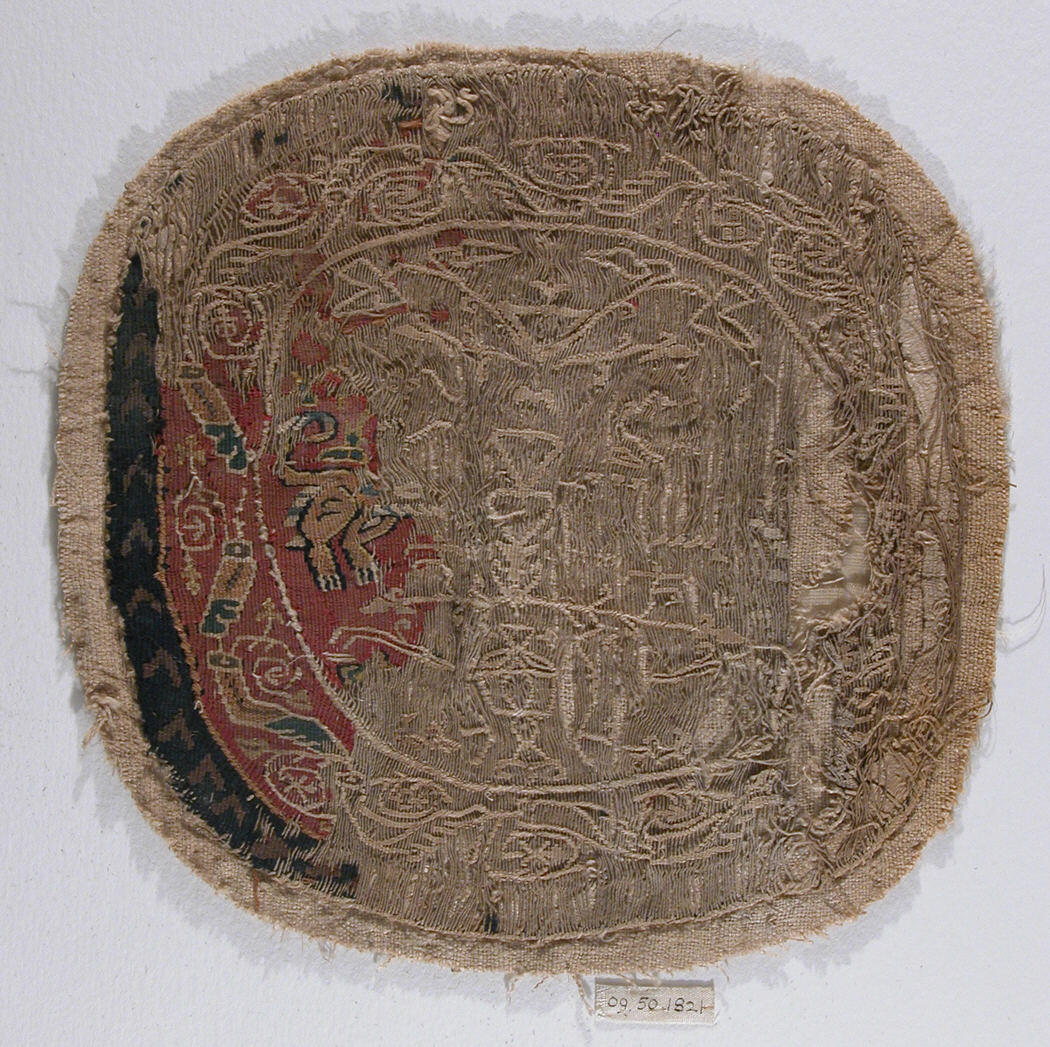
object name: roundel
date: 501-700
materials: linen, wool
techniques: weave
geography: egypt